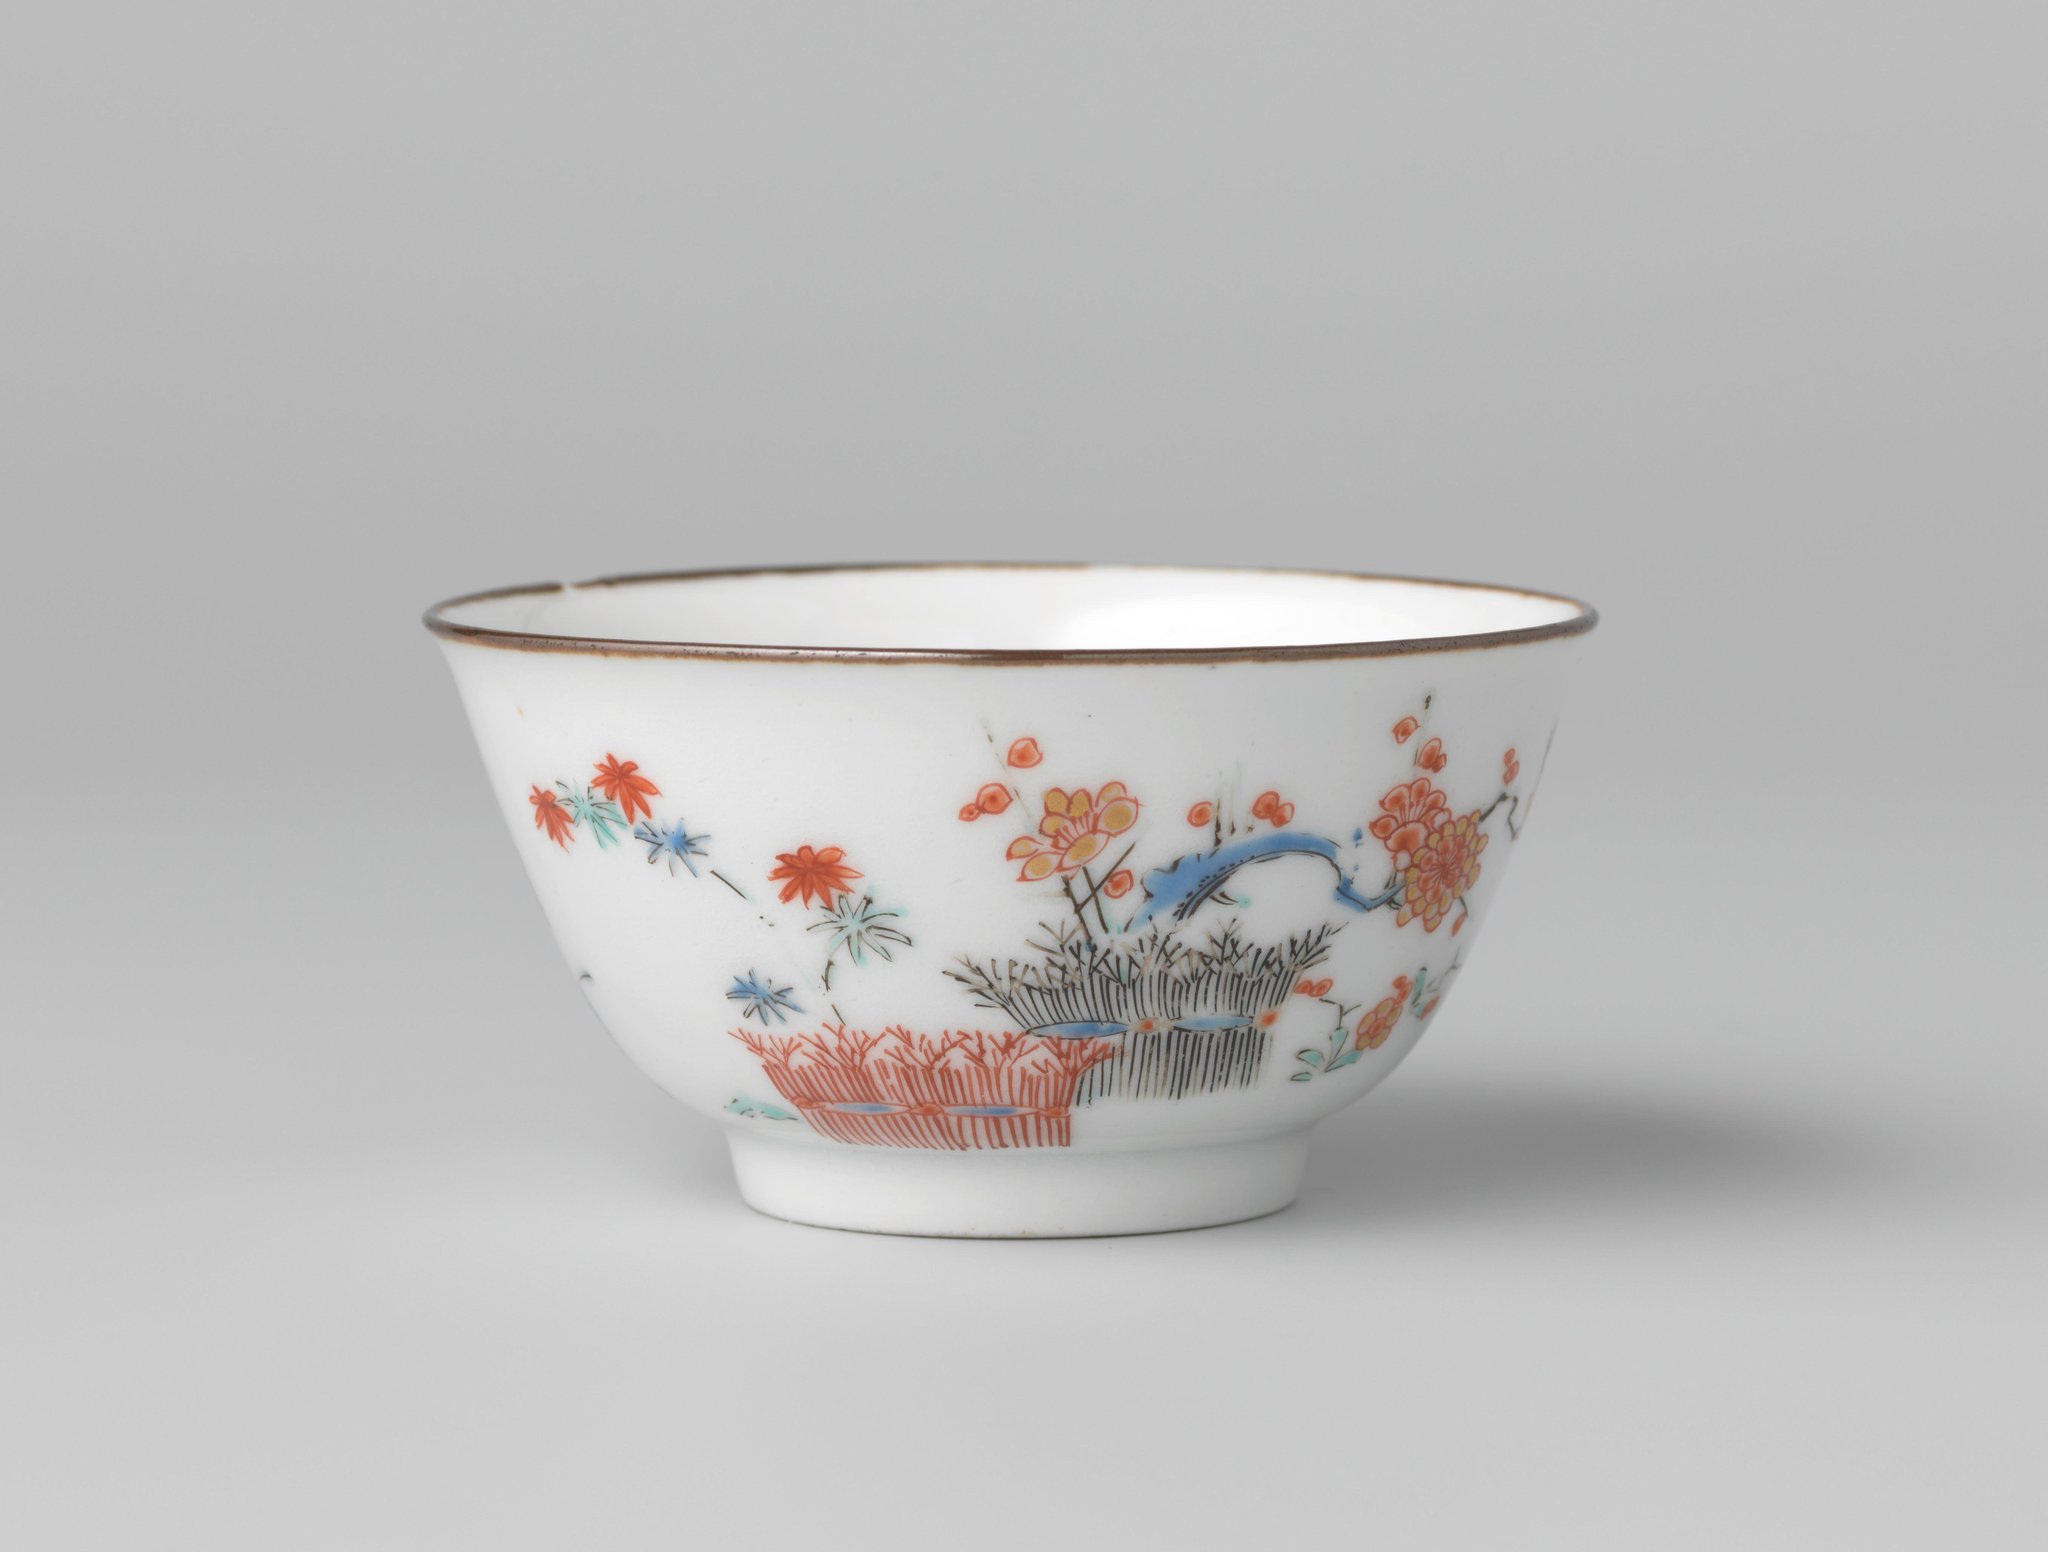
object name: cup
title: Cup with hedges, bamboo, prunus and hoo-bird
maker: Anonymous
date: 1670-1690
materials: glaze, gold, paint, porcelain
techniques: firing, gilding, turning, vitrification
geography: japan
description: Kop van porselein, beschilderd op het glazuur in blauw, rood, groen, geel, zwart en goud met bamboe, prunus en nog een plant bij gebonden heggen, en een hoo-vogel. Bruine rand. Een chip en een barst in de rand. Kakiemon.